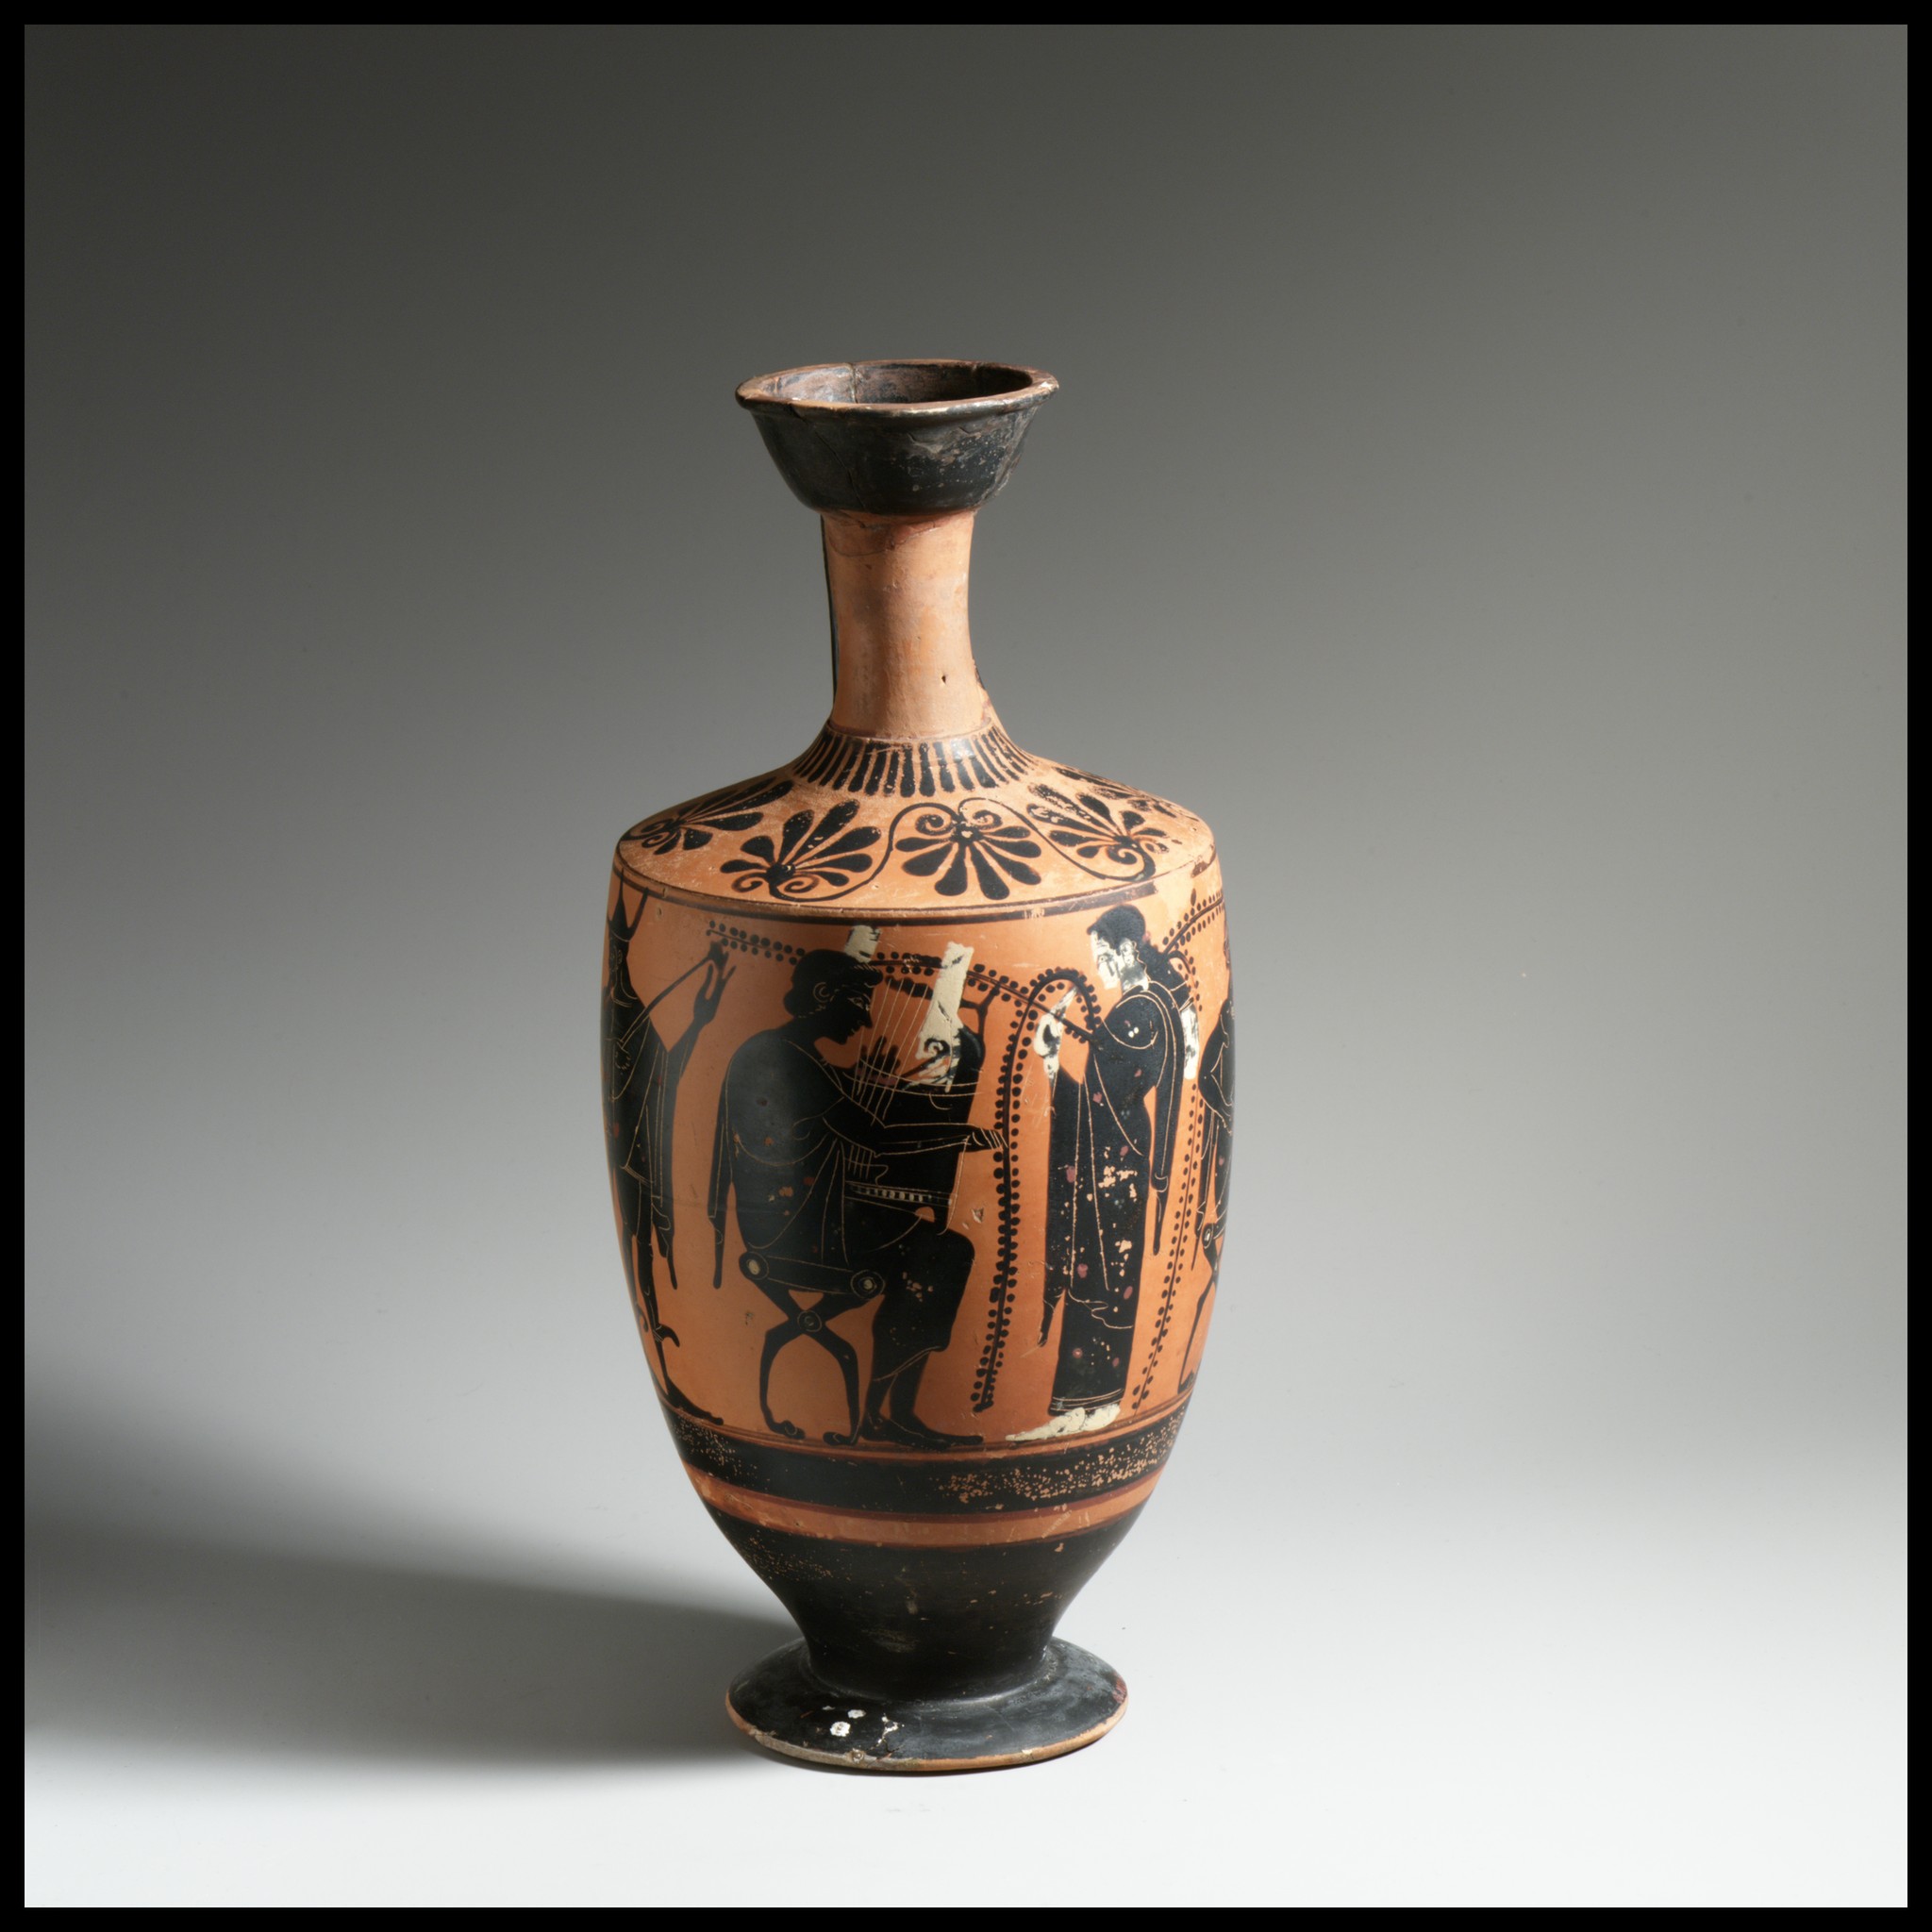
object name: lekythos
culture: greek, attic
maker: leagros group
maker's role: artist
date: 7000-30 BCE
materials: terracotta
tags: women,apollo,dionysus,hermes,lyres